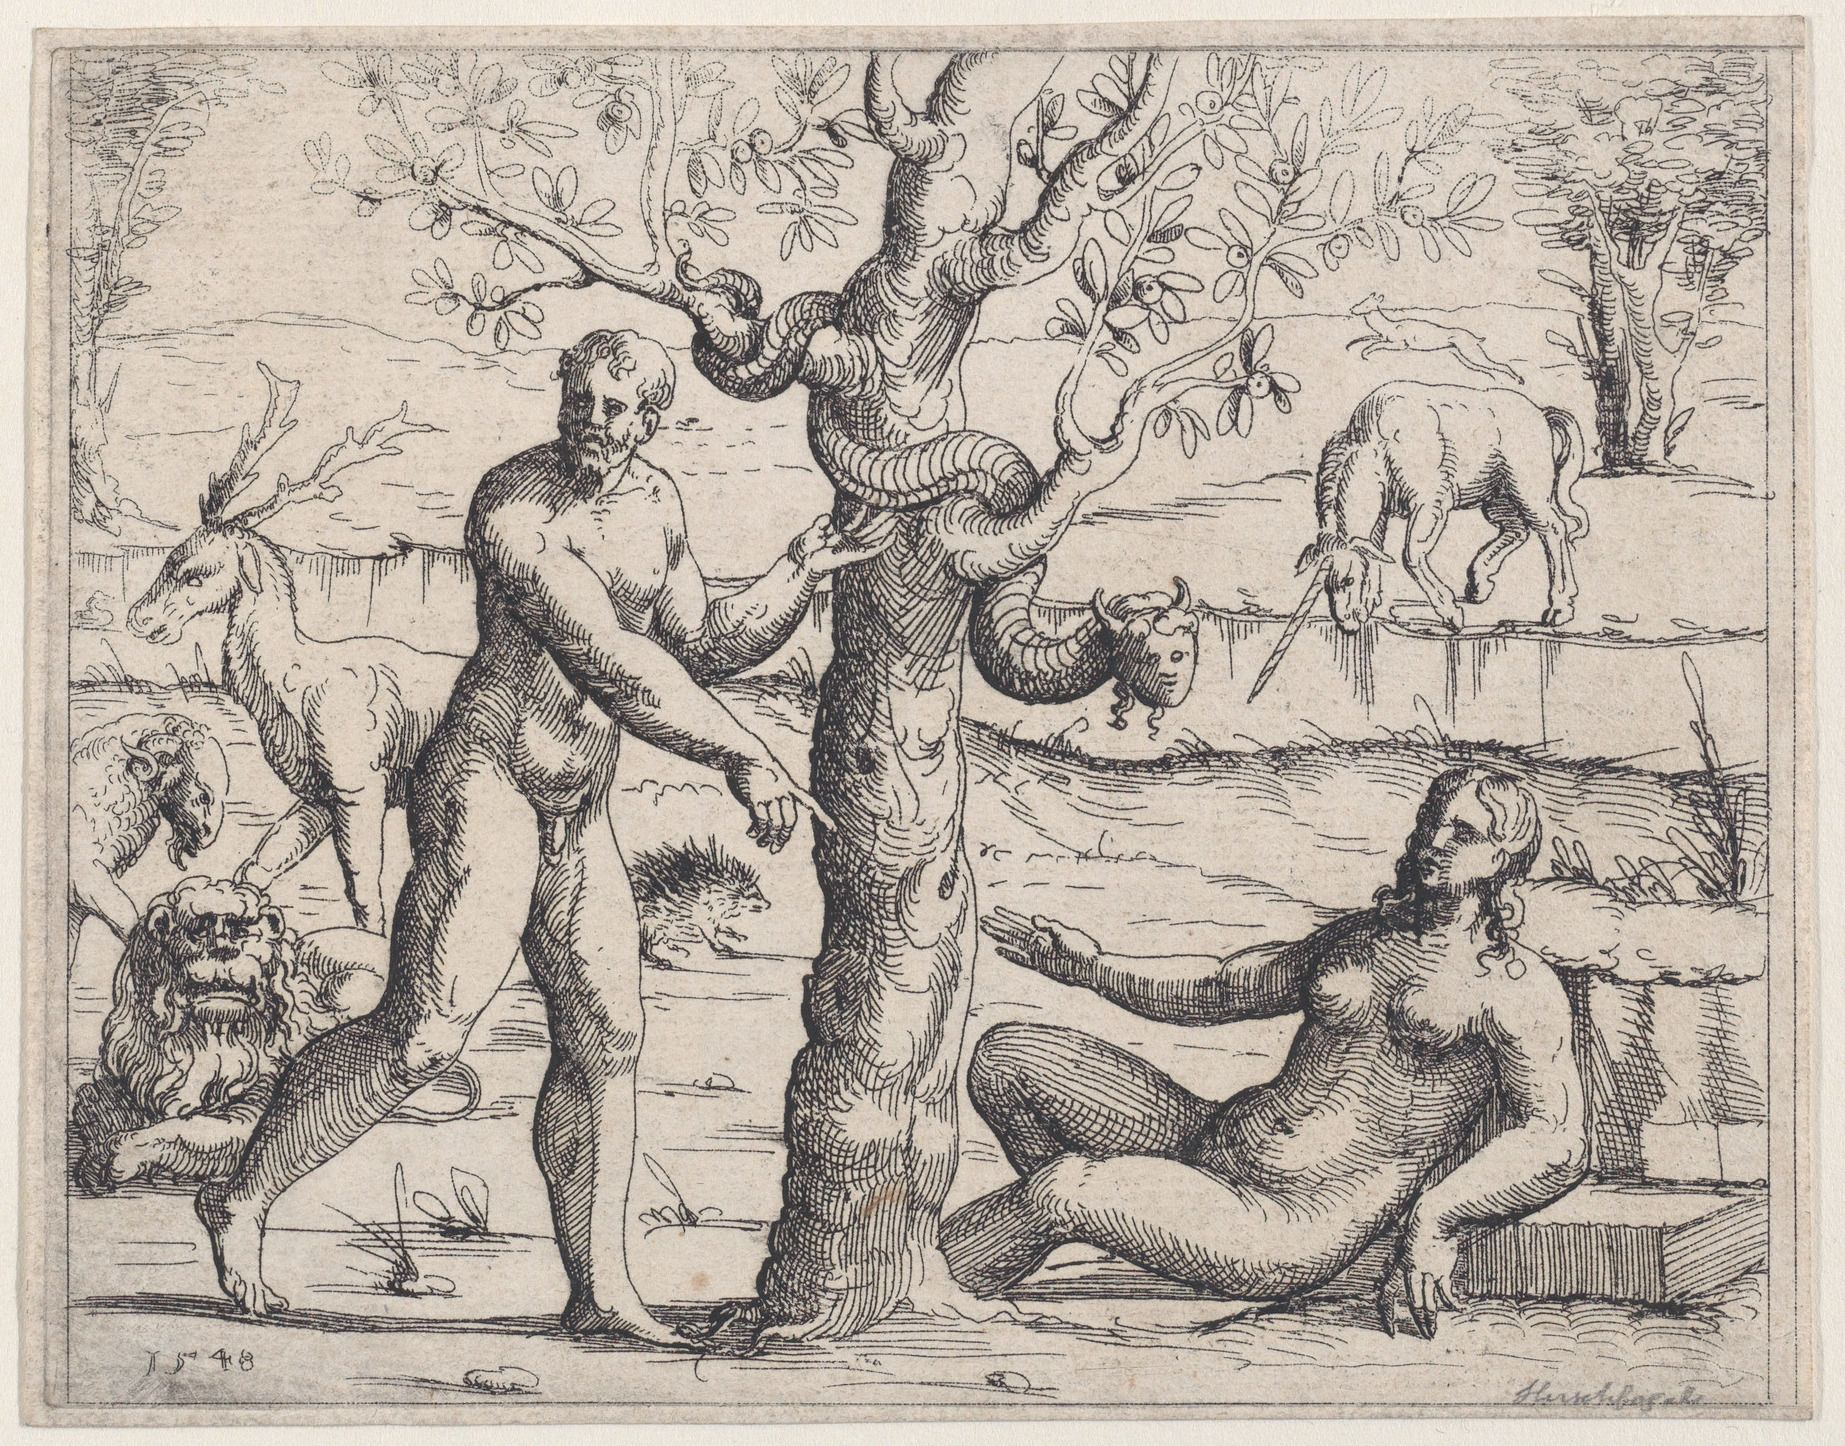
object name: print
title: Adam and Eve Eating the Forbidden Fruit, from "Old and New Testaments"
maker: augustin hirschvogel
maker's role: artist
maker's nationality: german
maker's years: 1503-1553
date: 1548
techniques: etching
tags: unicorns,deer,lions,snakes,adam,eve